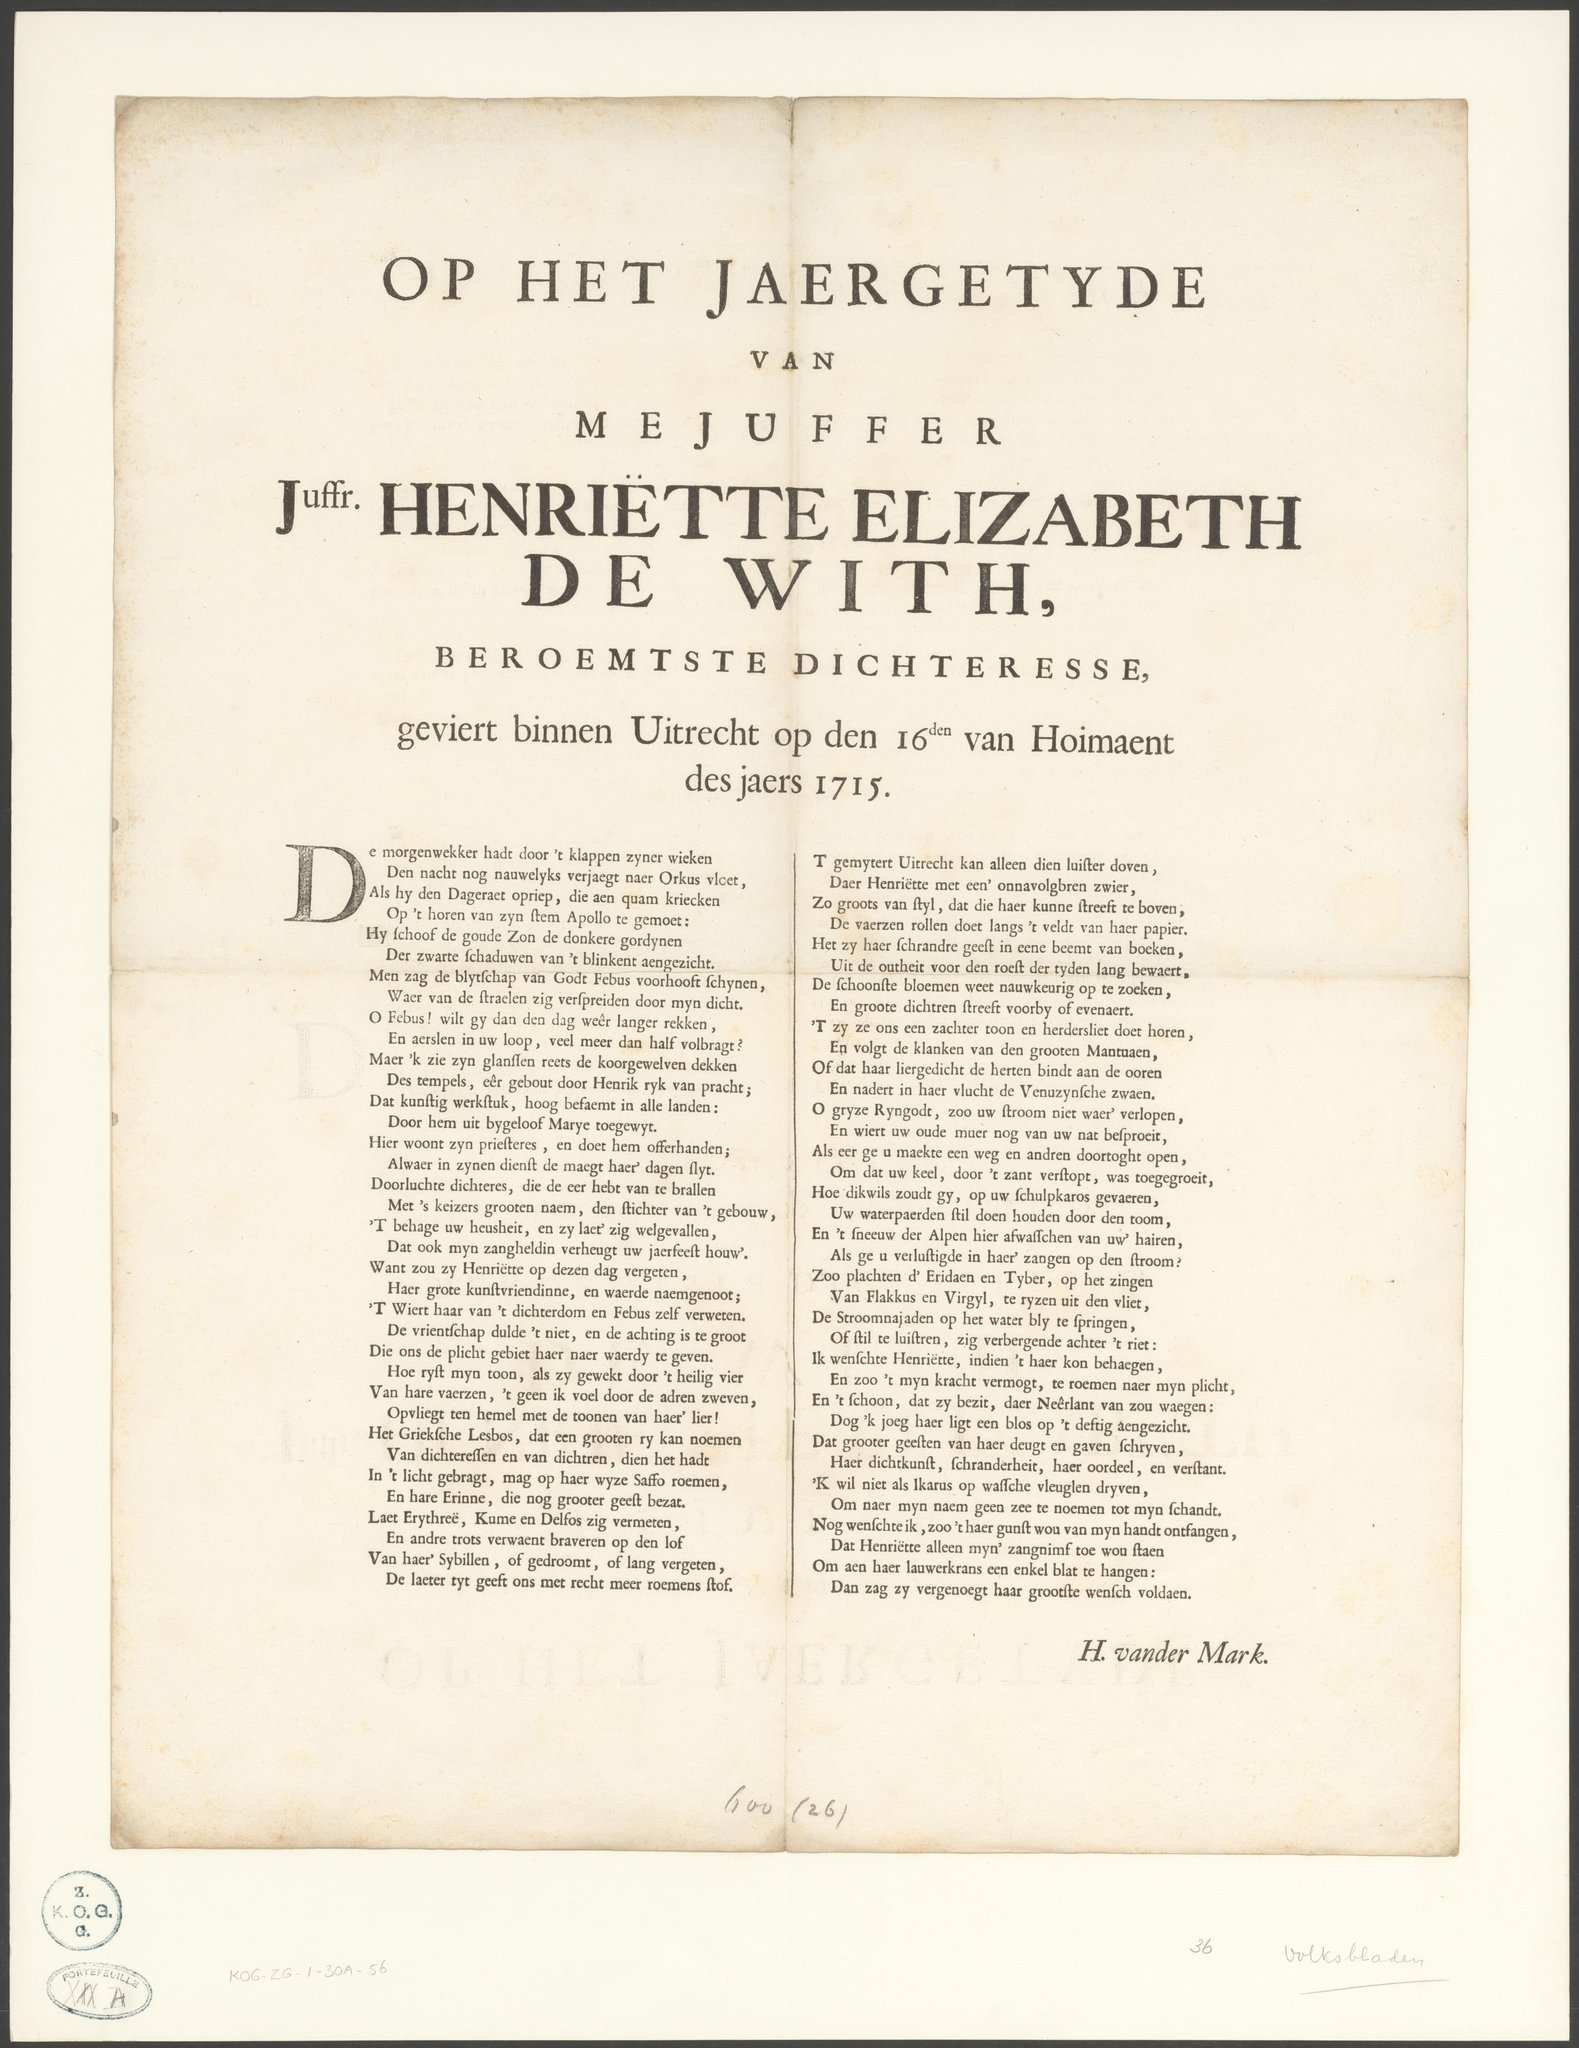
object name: text sheet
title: Op het jaergetyde van Mejuffer Juffr. Henriëtte Elizabeth de With, beroemtste dichteresse, geviert binnen Utrecht op den 16den van Hoimaent des jaers 1715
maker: hendrik van der mark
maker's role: dichter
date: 1715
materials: paper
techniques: letterpress printing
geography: netherlands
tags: birthday, writer, poet, author, fame ~ writer, 'poeta laureatus'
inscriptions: collector's mark, collector's mark: Lugt 1641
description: Blad met een gedrukte vers in twee kolommen ter gelegenheid van de verjaardag van de Utrechtse dichteres Henriëtte Elizabeth de With op 16 juli 1715. Onderwerpsrubrieken binnen de Atlas Zeden en Gewoonten: Nieuwjaars- en kermiswenschen.